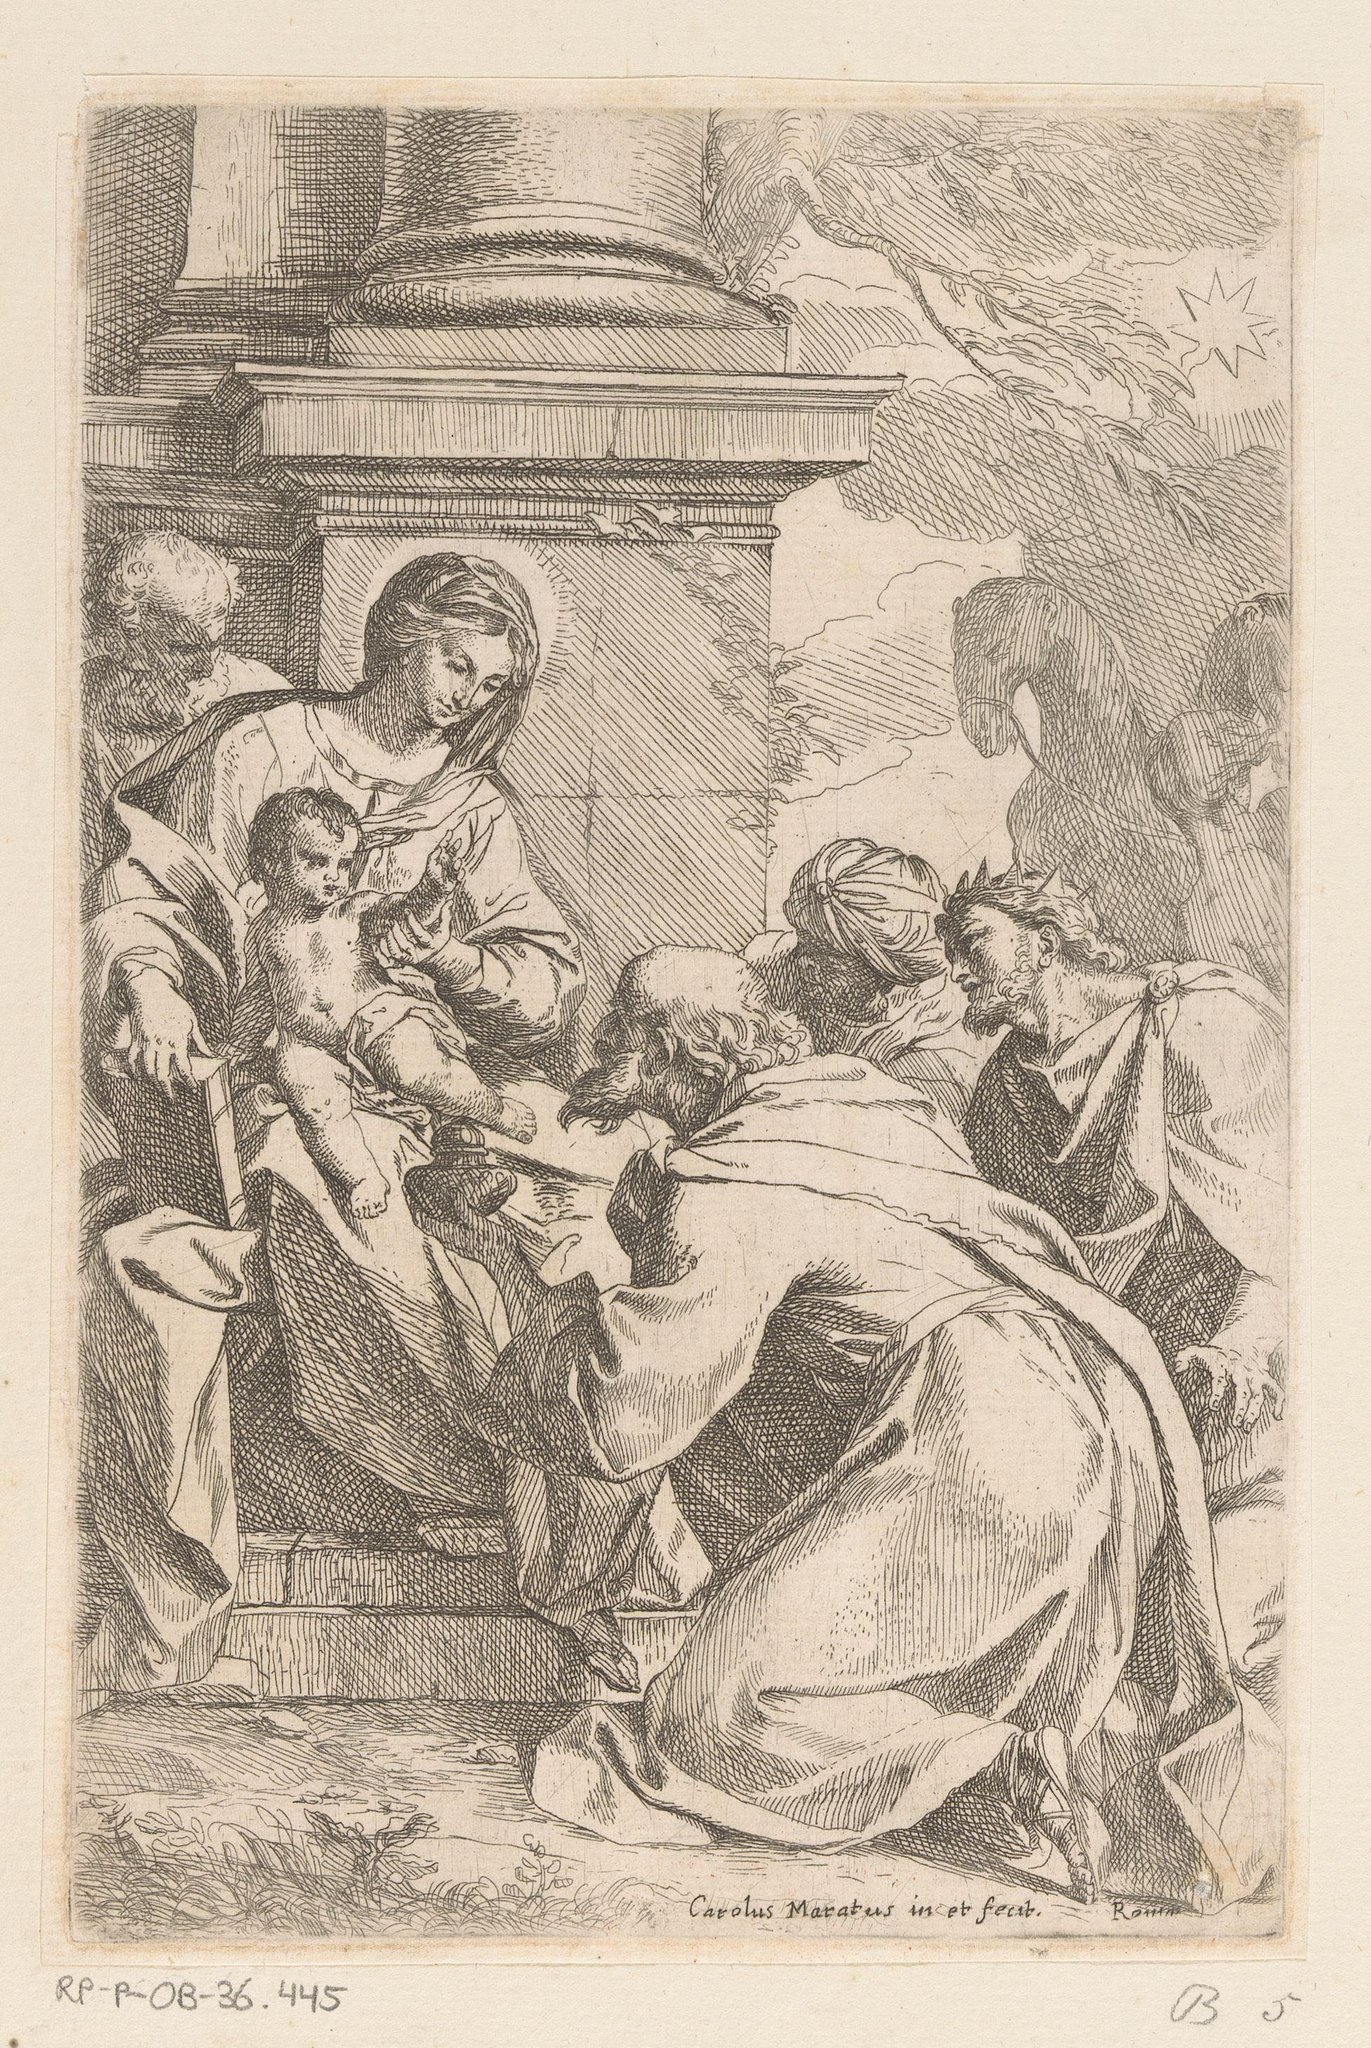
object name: print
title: Aanbidding door de koningen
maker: carlo maratta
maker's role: draughtsman, painter, print maker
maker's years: 1625-1713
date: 1635-1713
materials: paper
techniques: etching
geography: rome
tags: adoration of the kings: the wise men present their gifts to the christ-child (gold, frankincense and myrrh) (+ donor(s), supplicant(s), whether or not with patron saint(s))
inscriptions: collector's mark: Lugt 240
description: Maria zit met het Christuskind op schoot. Jozef zit achter hen. De drie koningen knielen voor het Christuskind. Op de achtergrond een kameel.